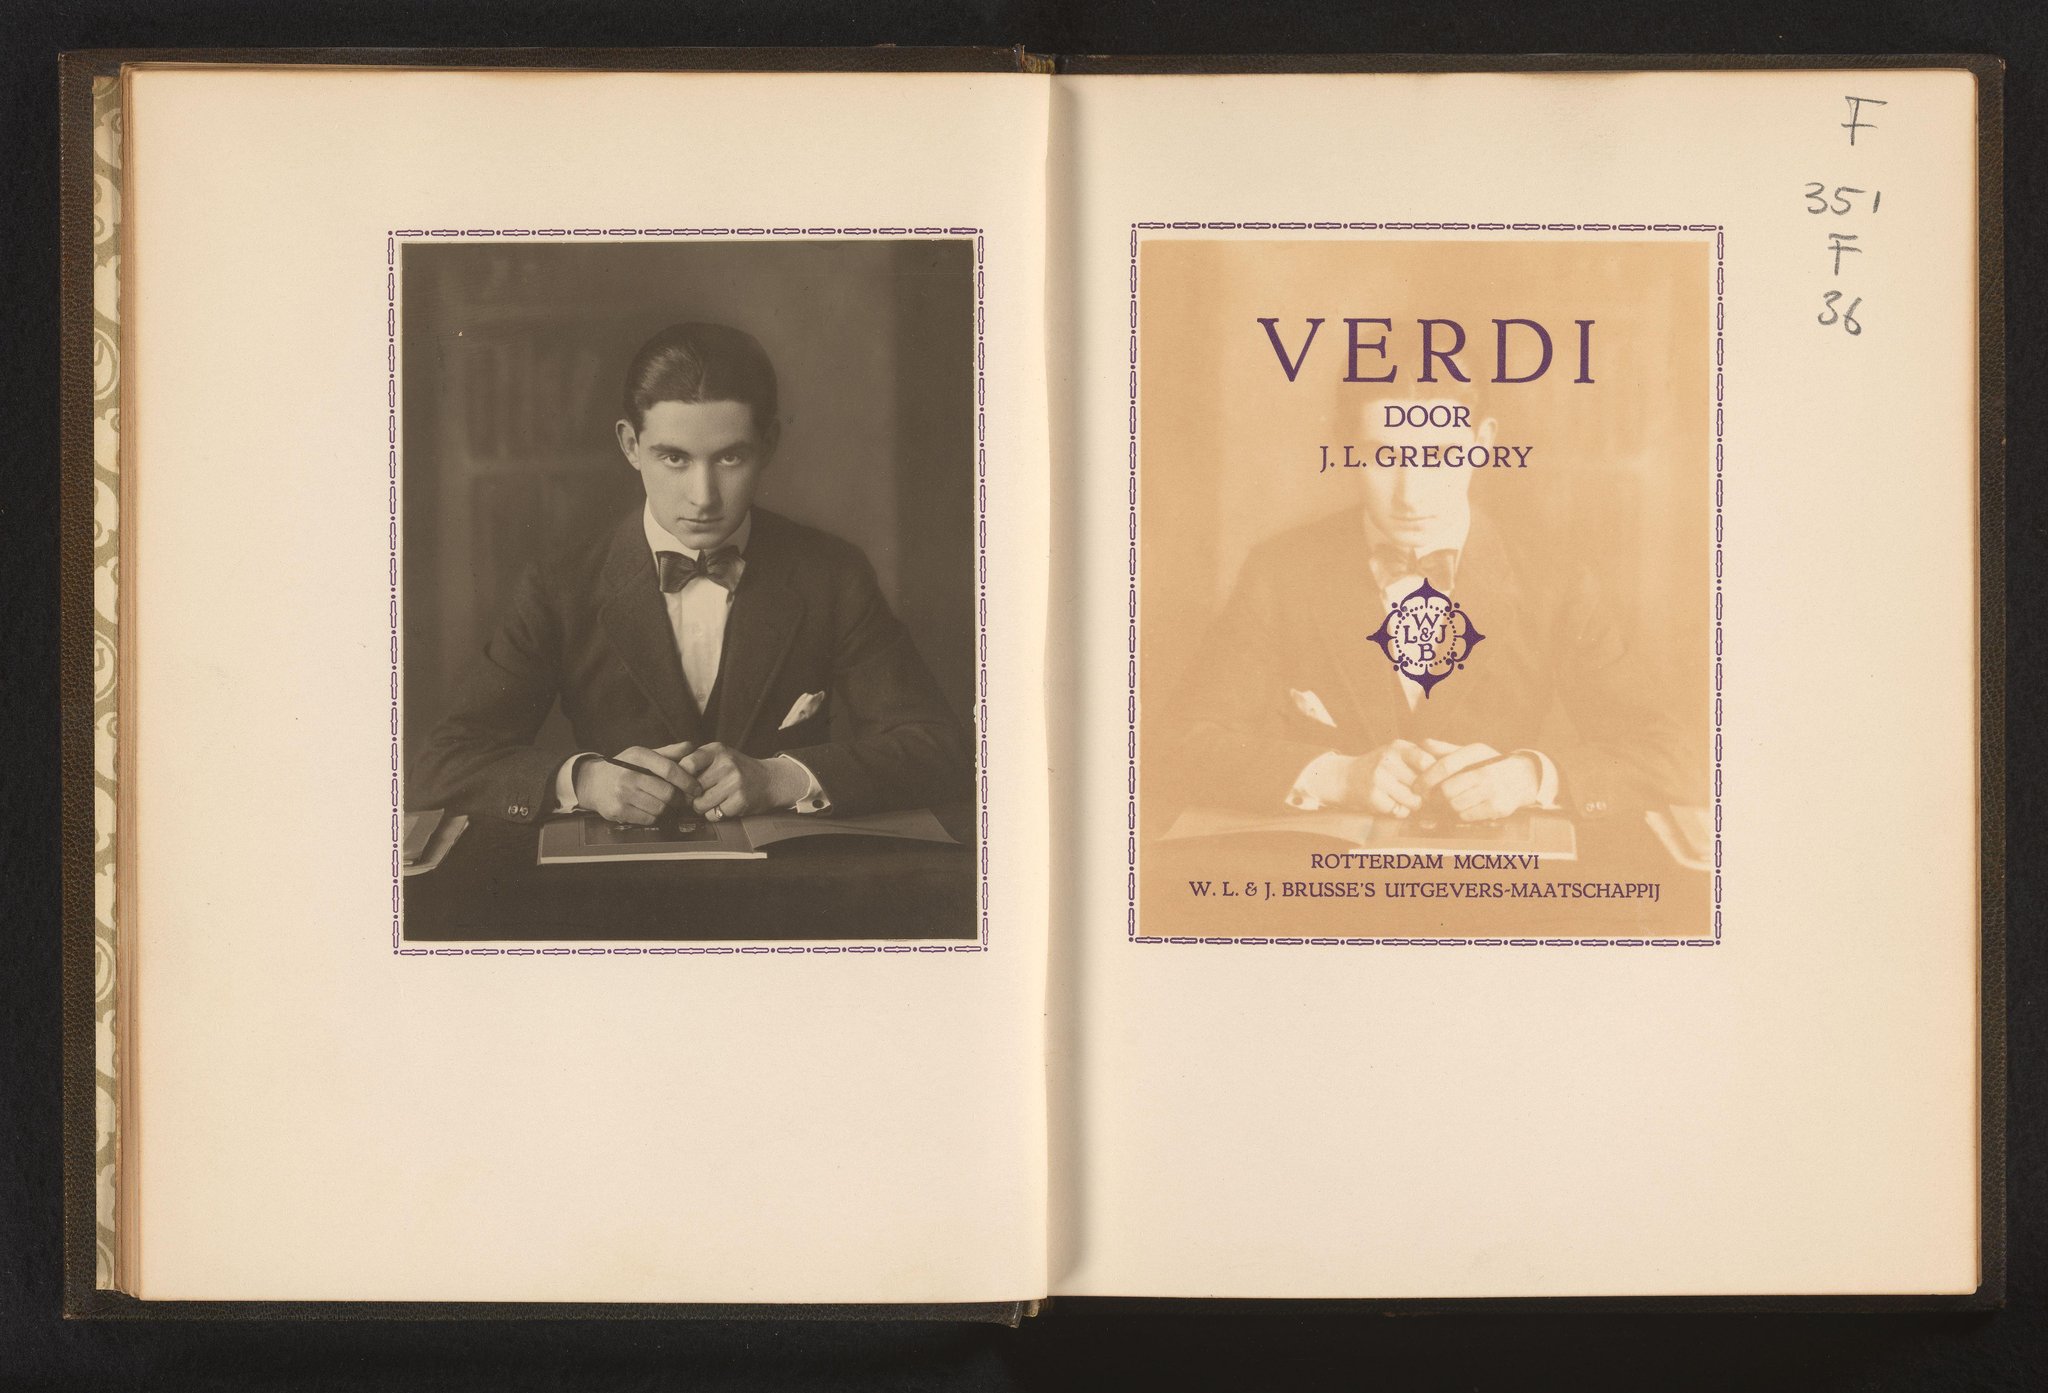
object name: photograph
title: Portret van een onbekende jongeman zittend aan een bureau, mogelijk Jan Lodewijk Pierson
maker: Anonymous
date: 1911-1916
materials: paper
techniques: carbon print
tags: writing-table, writing-desk, youth, adolescent, anonymous historical person portrayed